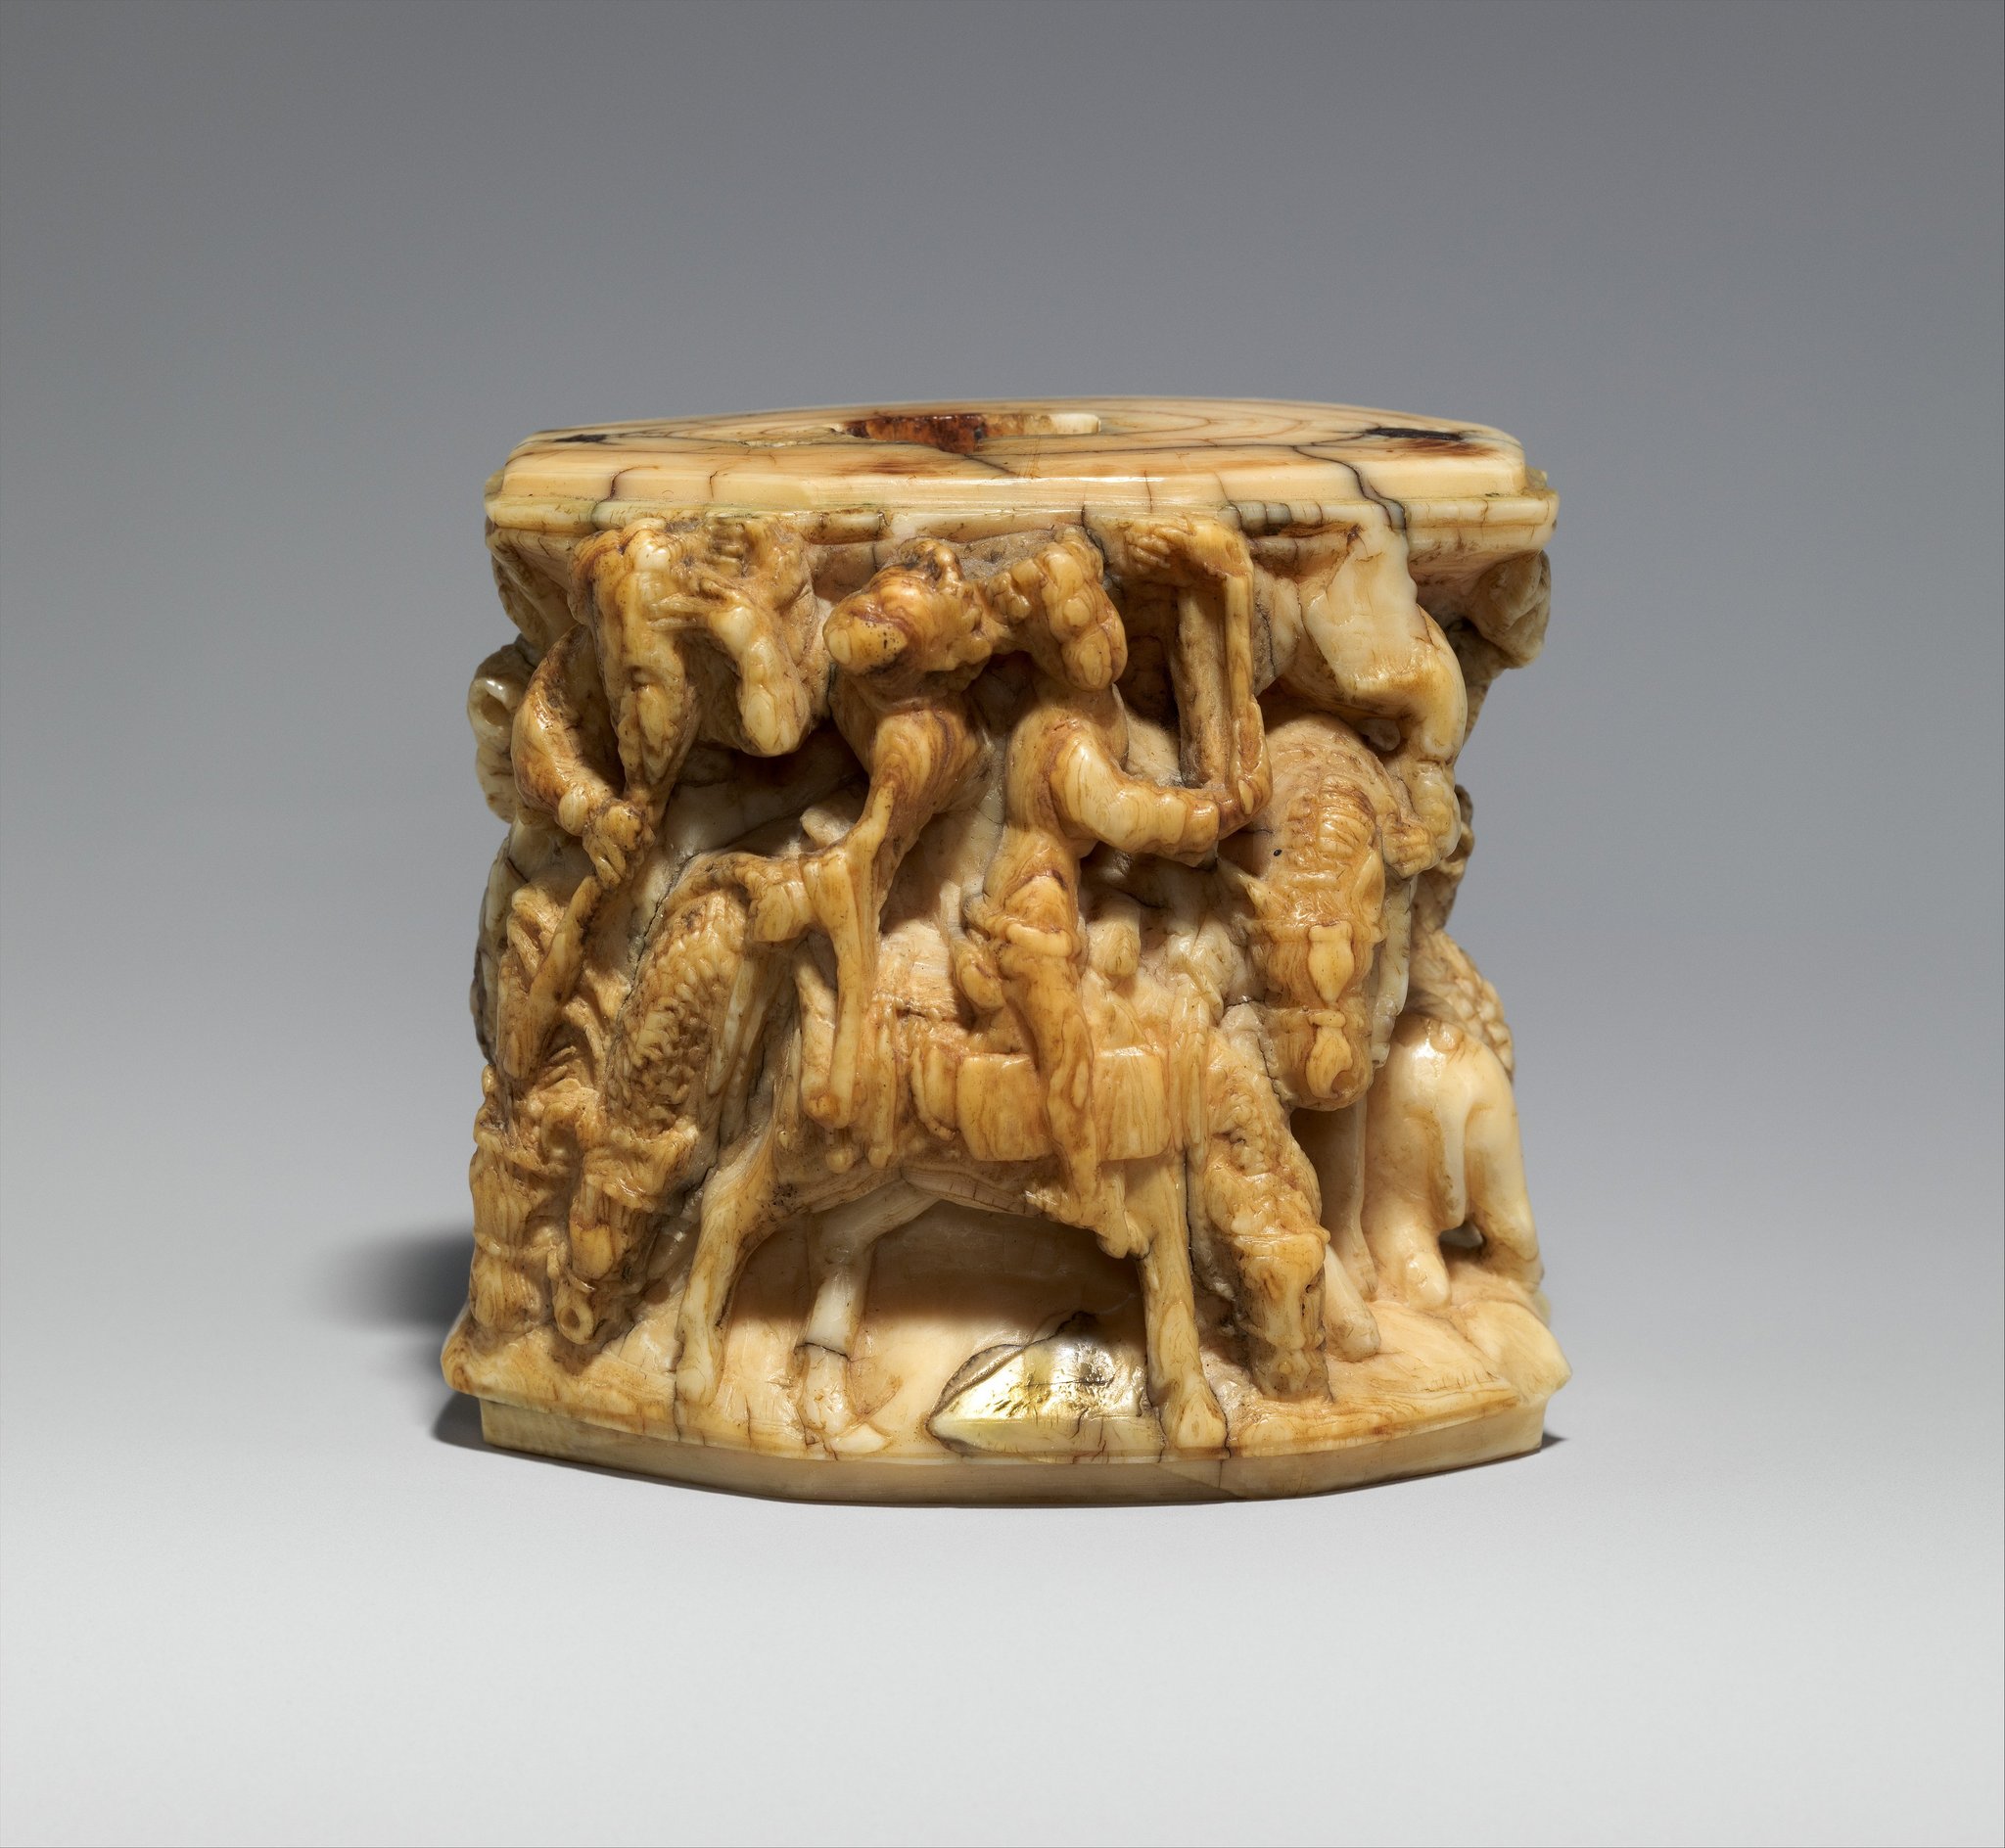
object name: mount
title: Decorative Mount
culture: german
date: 1375-1400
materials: ivory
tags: men,horses,lions